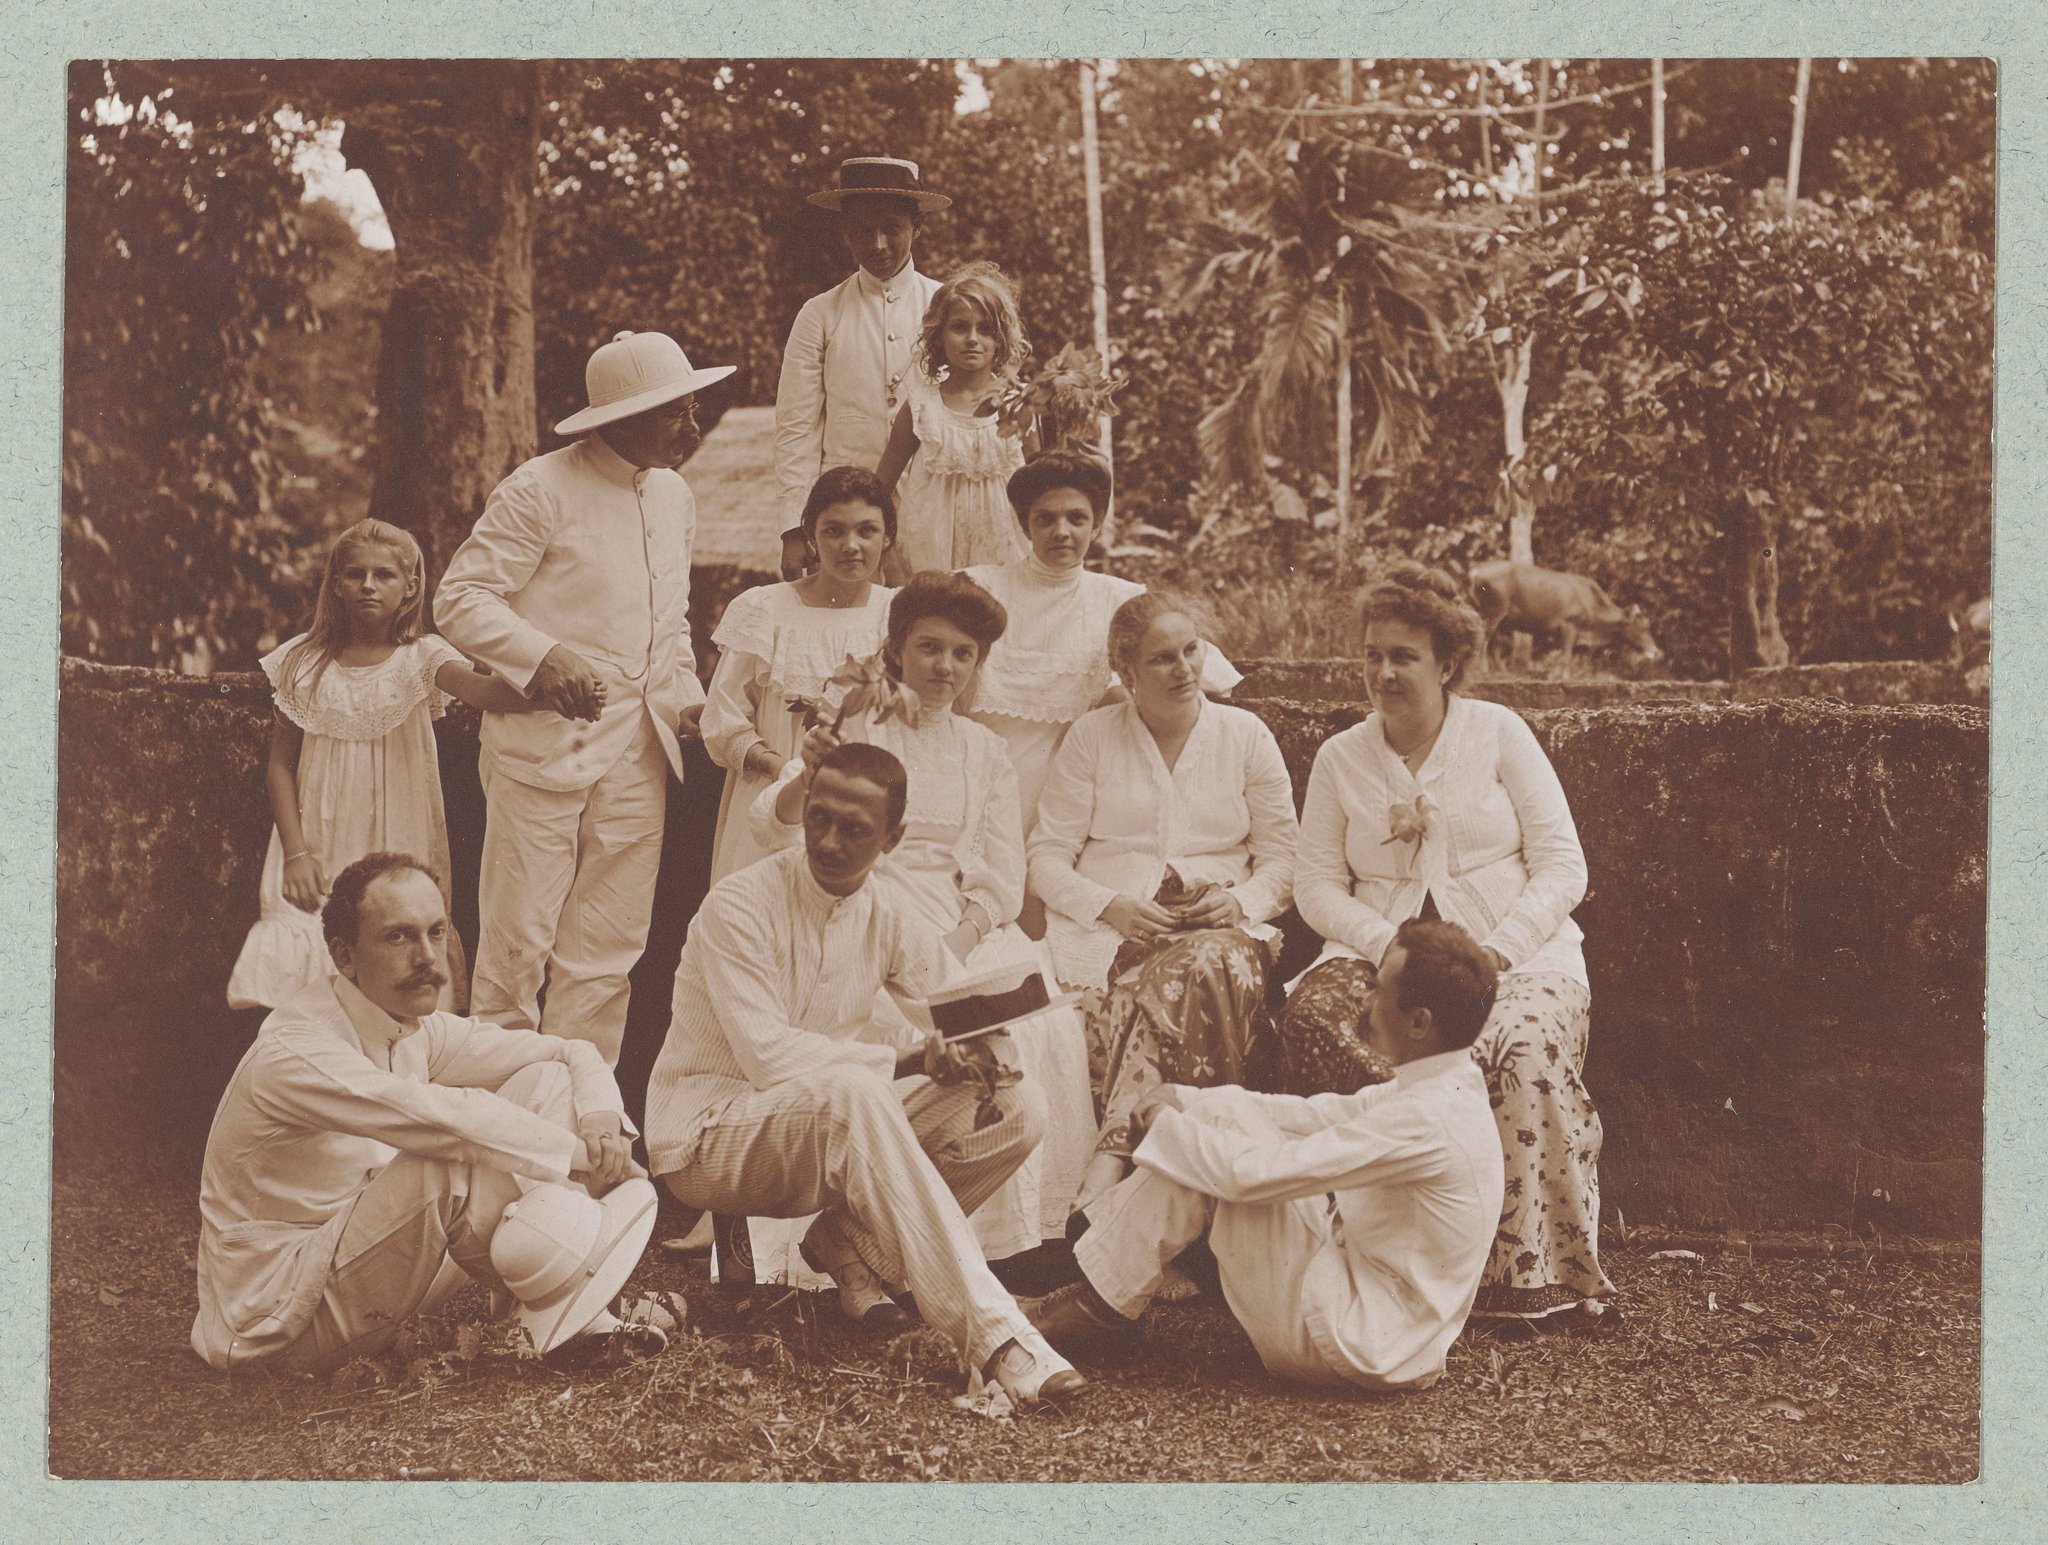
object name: photograph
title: Photographieën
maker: frits freerks fontein fz.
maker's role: fotograaf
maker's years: 1882-1928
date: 1910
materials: cardboard, paper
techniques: gelatin silver print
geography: madura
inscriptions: caption: ‘Batoewan bij Soemenep 1910’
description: De mannen dragen witte tropenuniformen waarvan een man met tropenhelm, twee andere mannen dragen een strooien hoed, de vrouwen dragen witte jurken of batik rokken met witte hes. Foto uit album 'Photographieën".